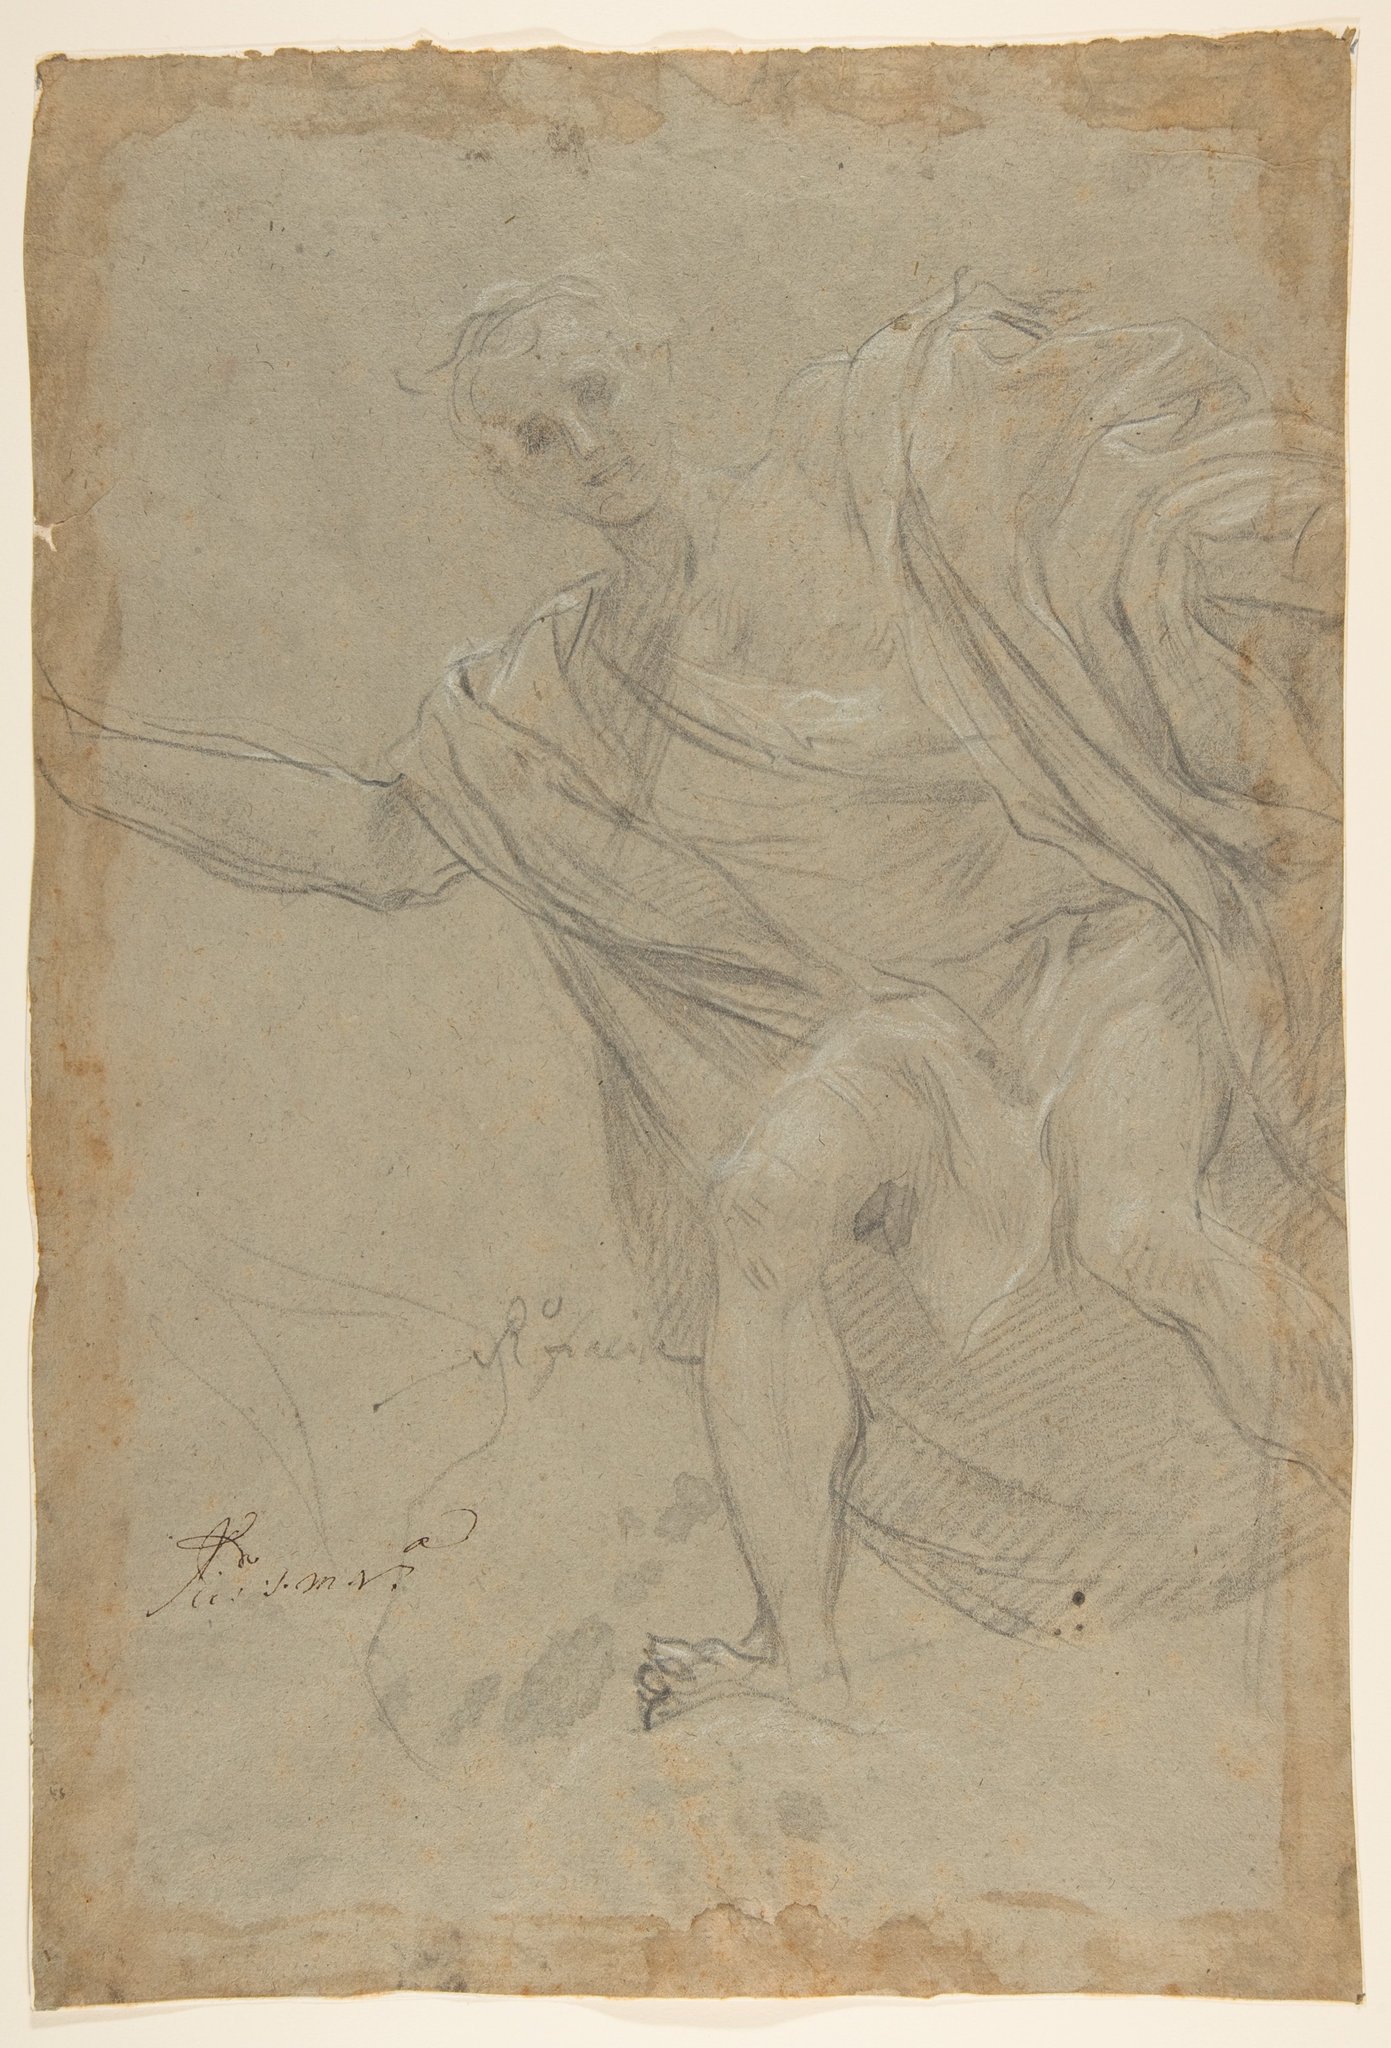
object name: drawing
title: Standing Draped Male Figure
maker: baldassarre franceschini (il volterrano)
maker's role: artist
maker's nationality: italian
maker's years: 1611-1690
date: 1550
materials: chalk, paper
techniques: highlighting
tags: men